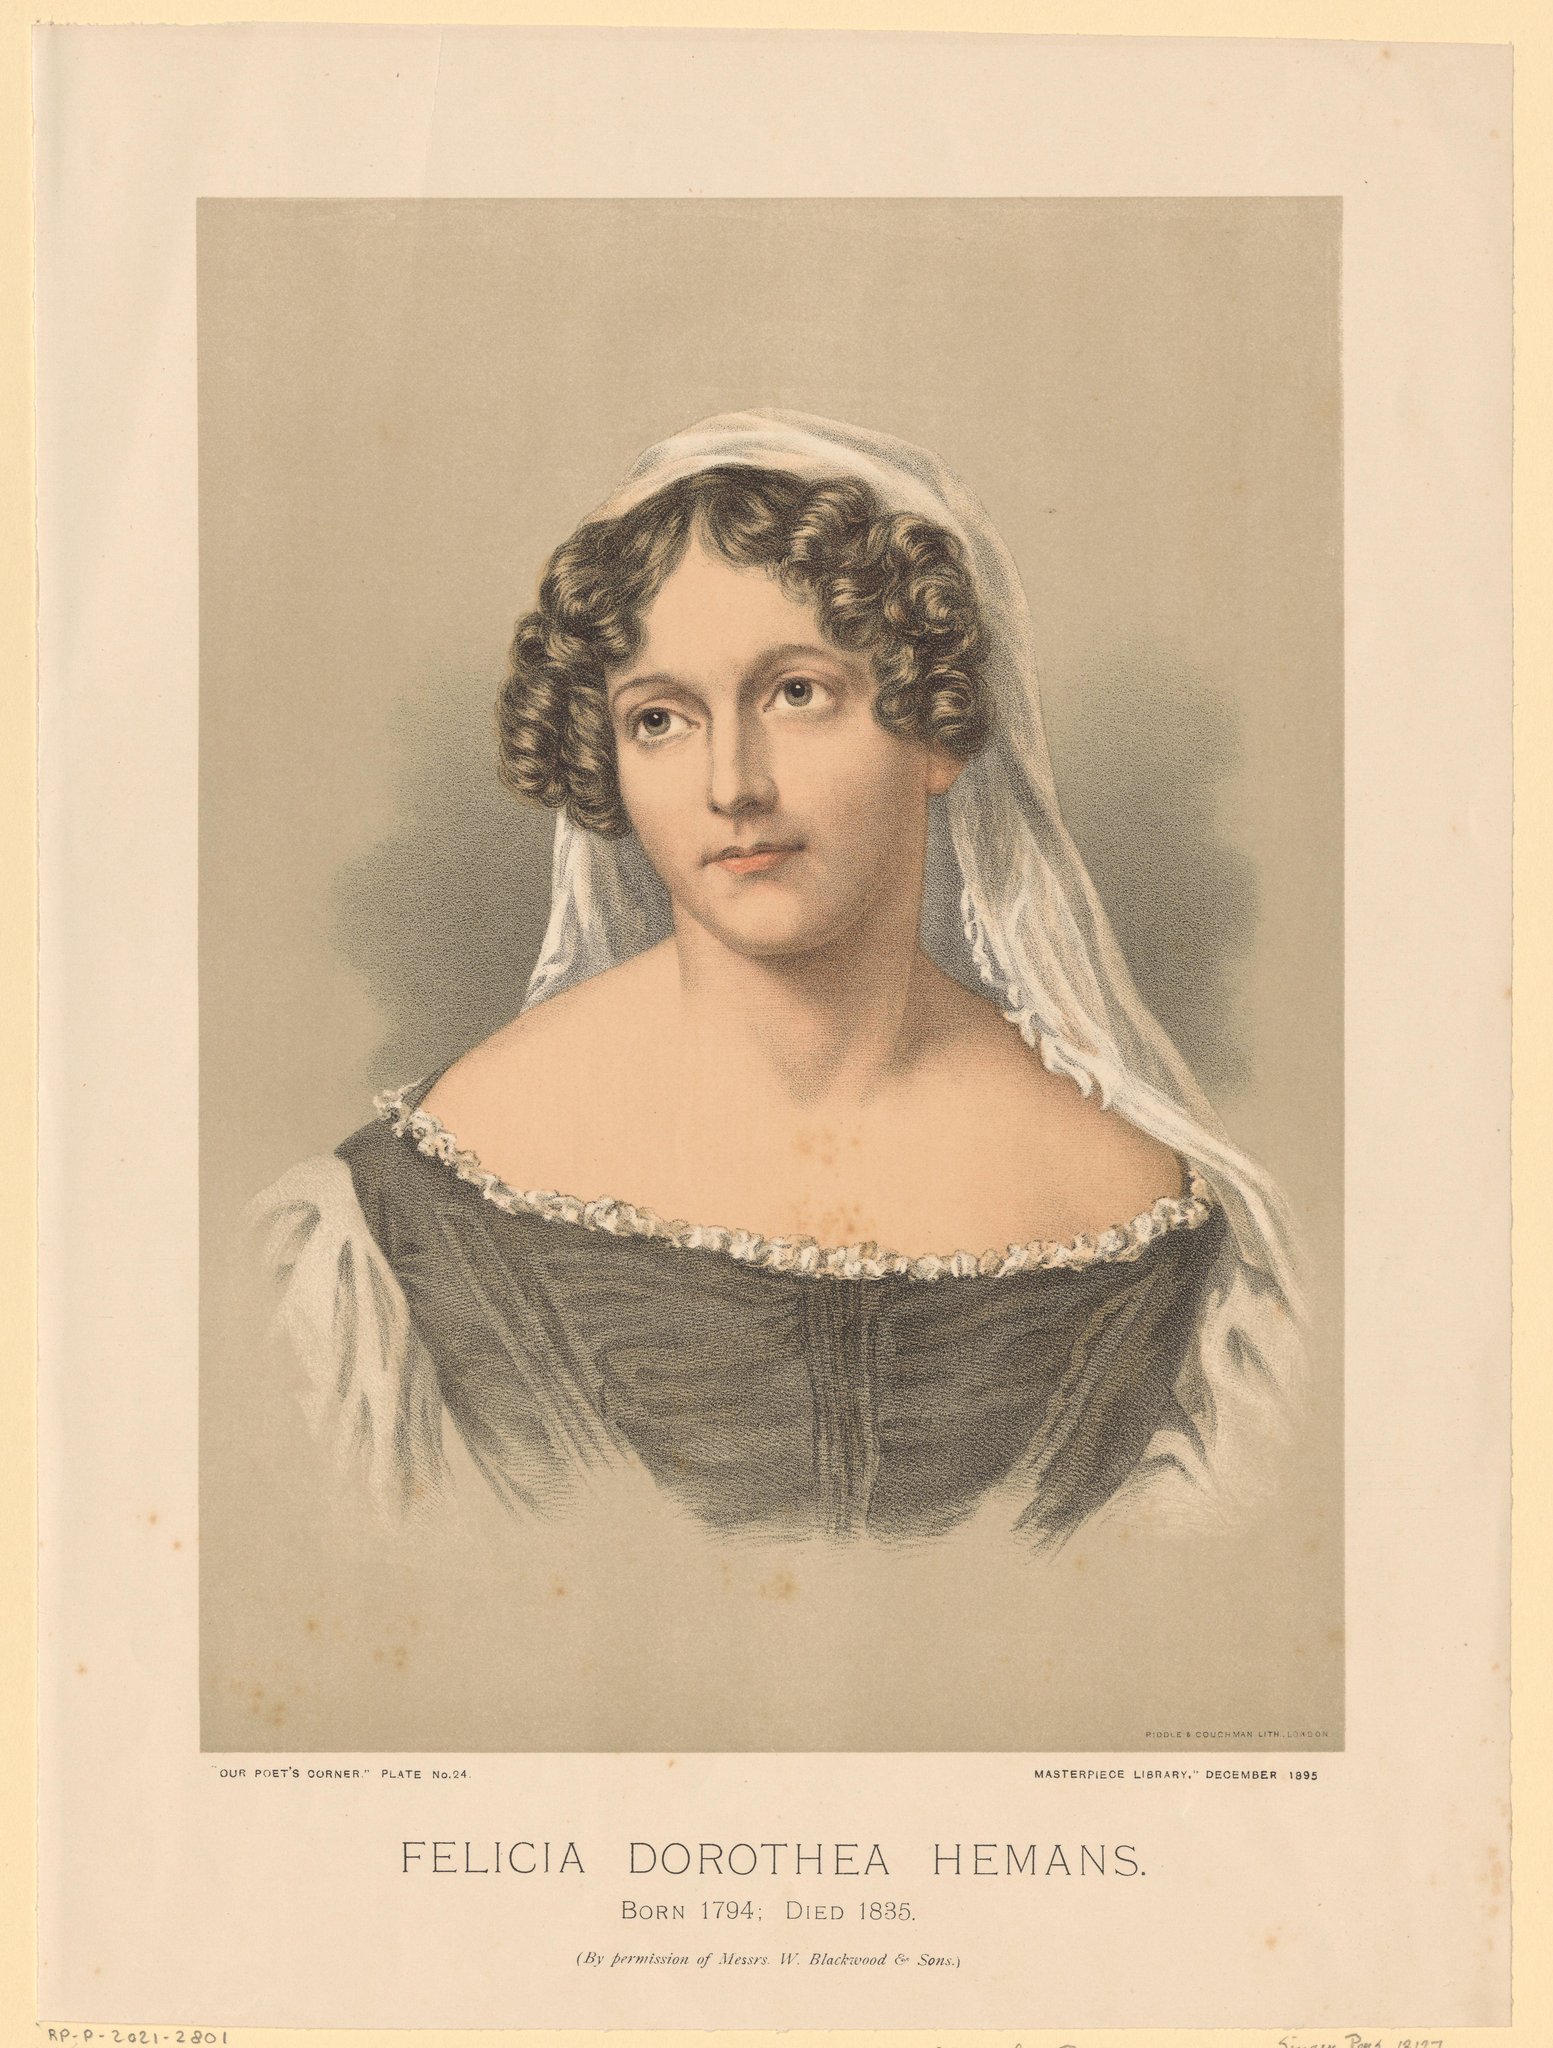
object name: print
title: Portret van Felicia Dorothea Hemans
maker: Anonymous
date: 1812-1895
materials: paper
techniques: tone lithography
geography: london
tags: historical persons - bb - woman, writer, poet, author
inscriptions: date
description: Prent uit de prentserie of publicatie: Our Poets' Corner. A Portrait Album of Famous Poets. Londen: Masterpiece Library, 1895.